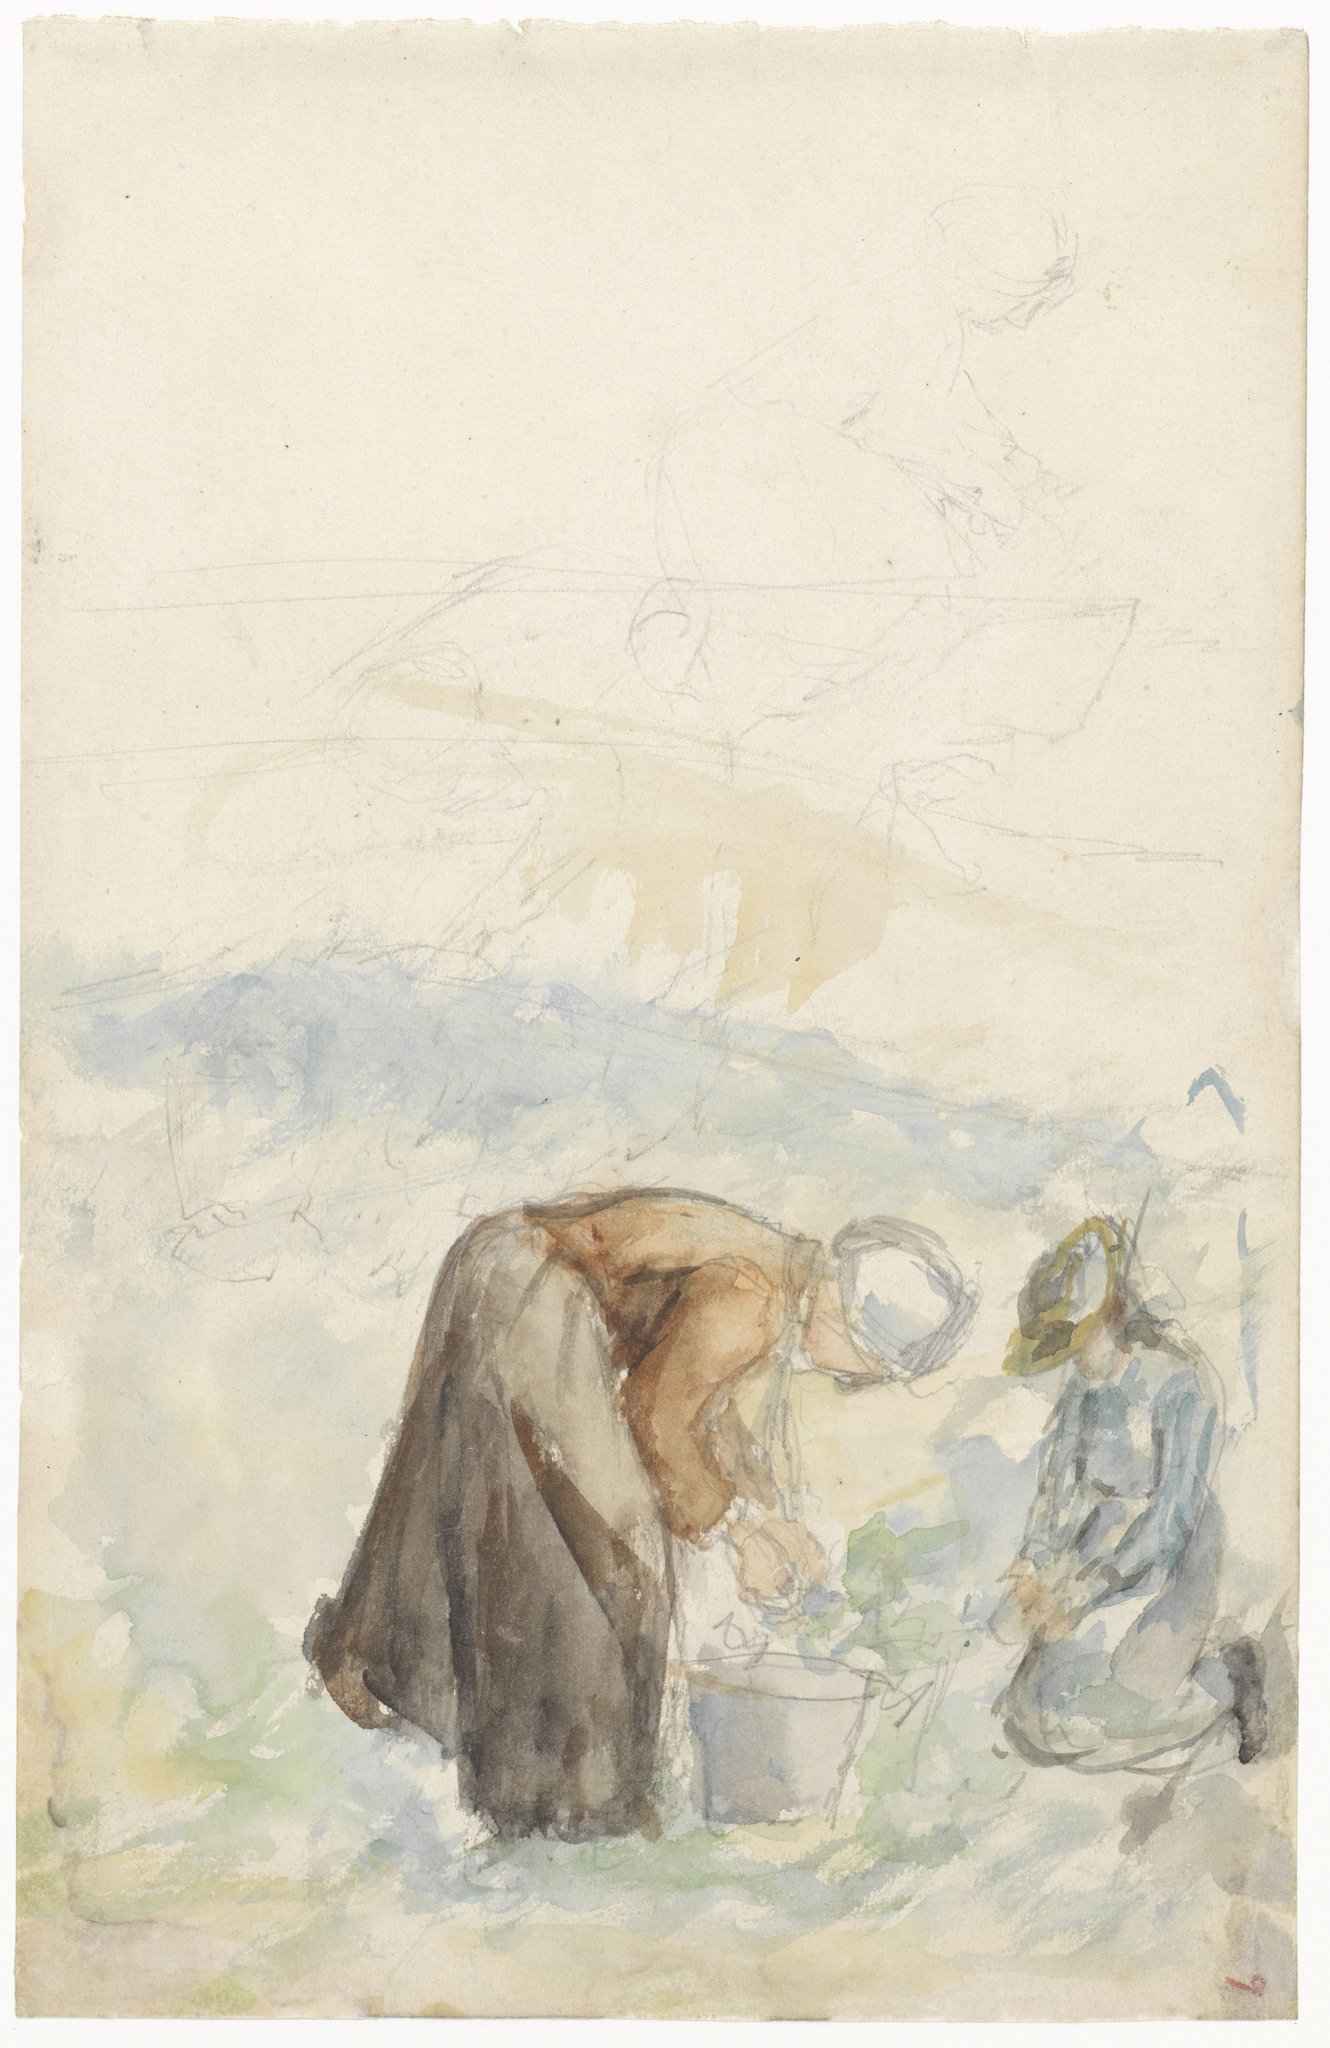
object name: drawing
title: Twee op het land werkende vrouwen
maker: jozef israëls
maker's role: draughtsman, painter, print maker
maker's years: 1824-1911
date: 1834-1911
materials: paper, pencil, watercolor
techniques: brush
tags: reaping, picking, mowing ~ harvest